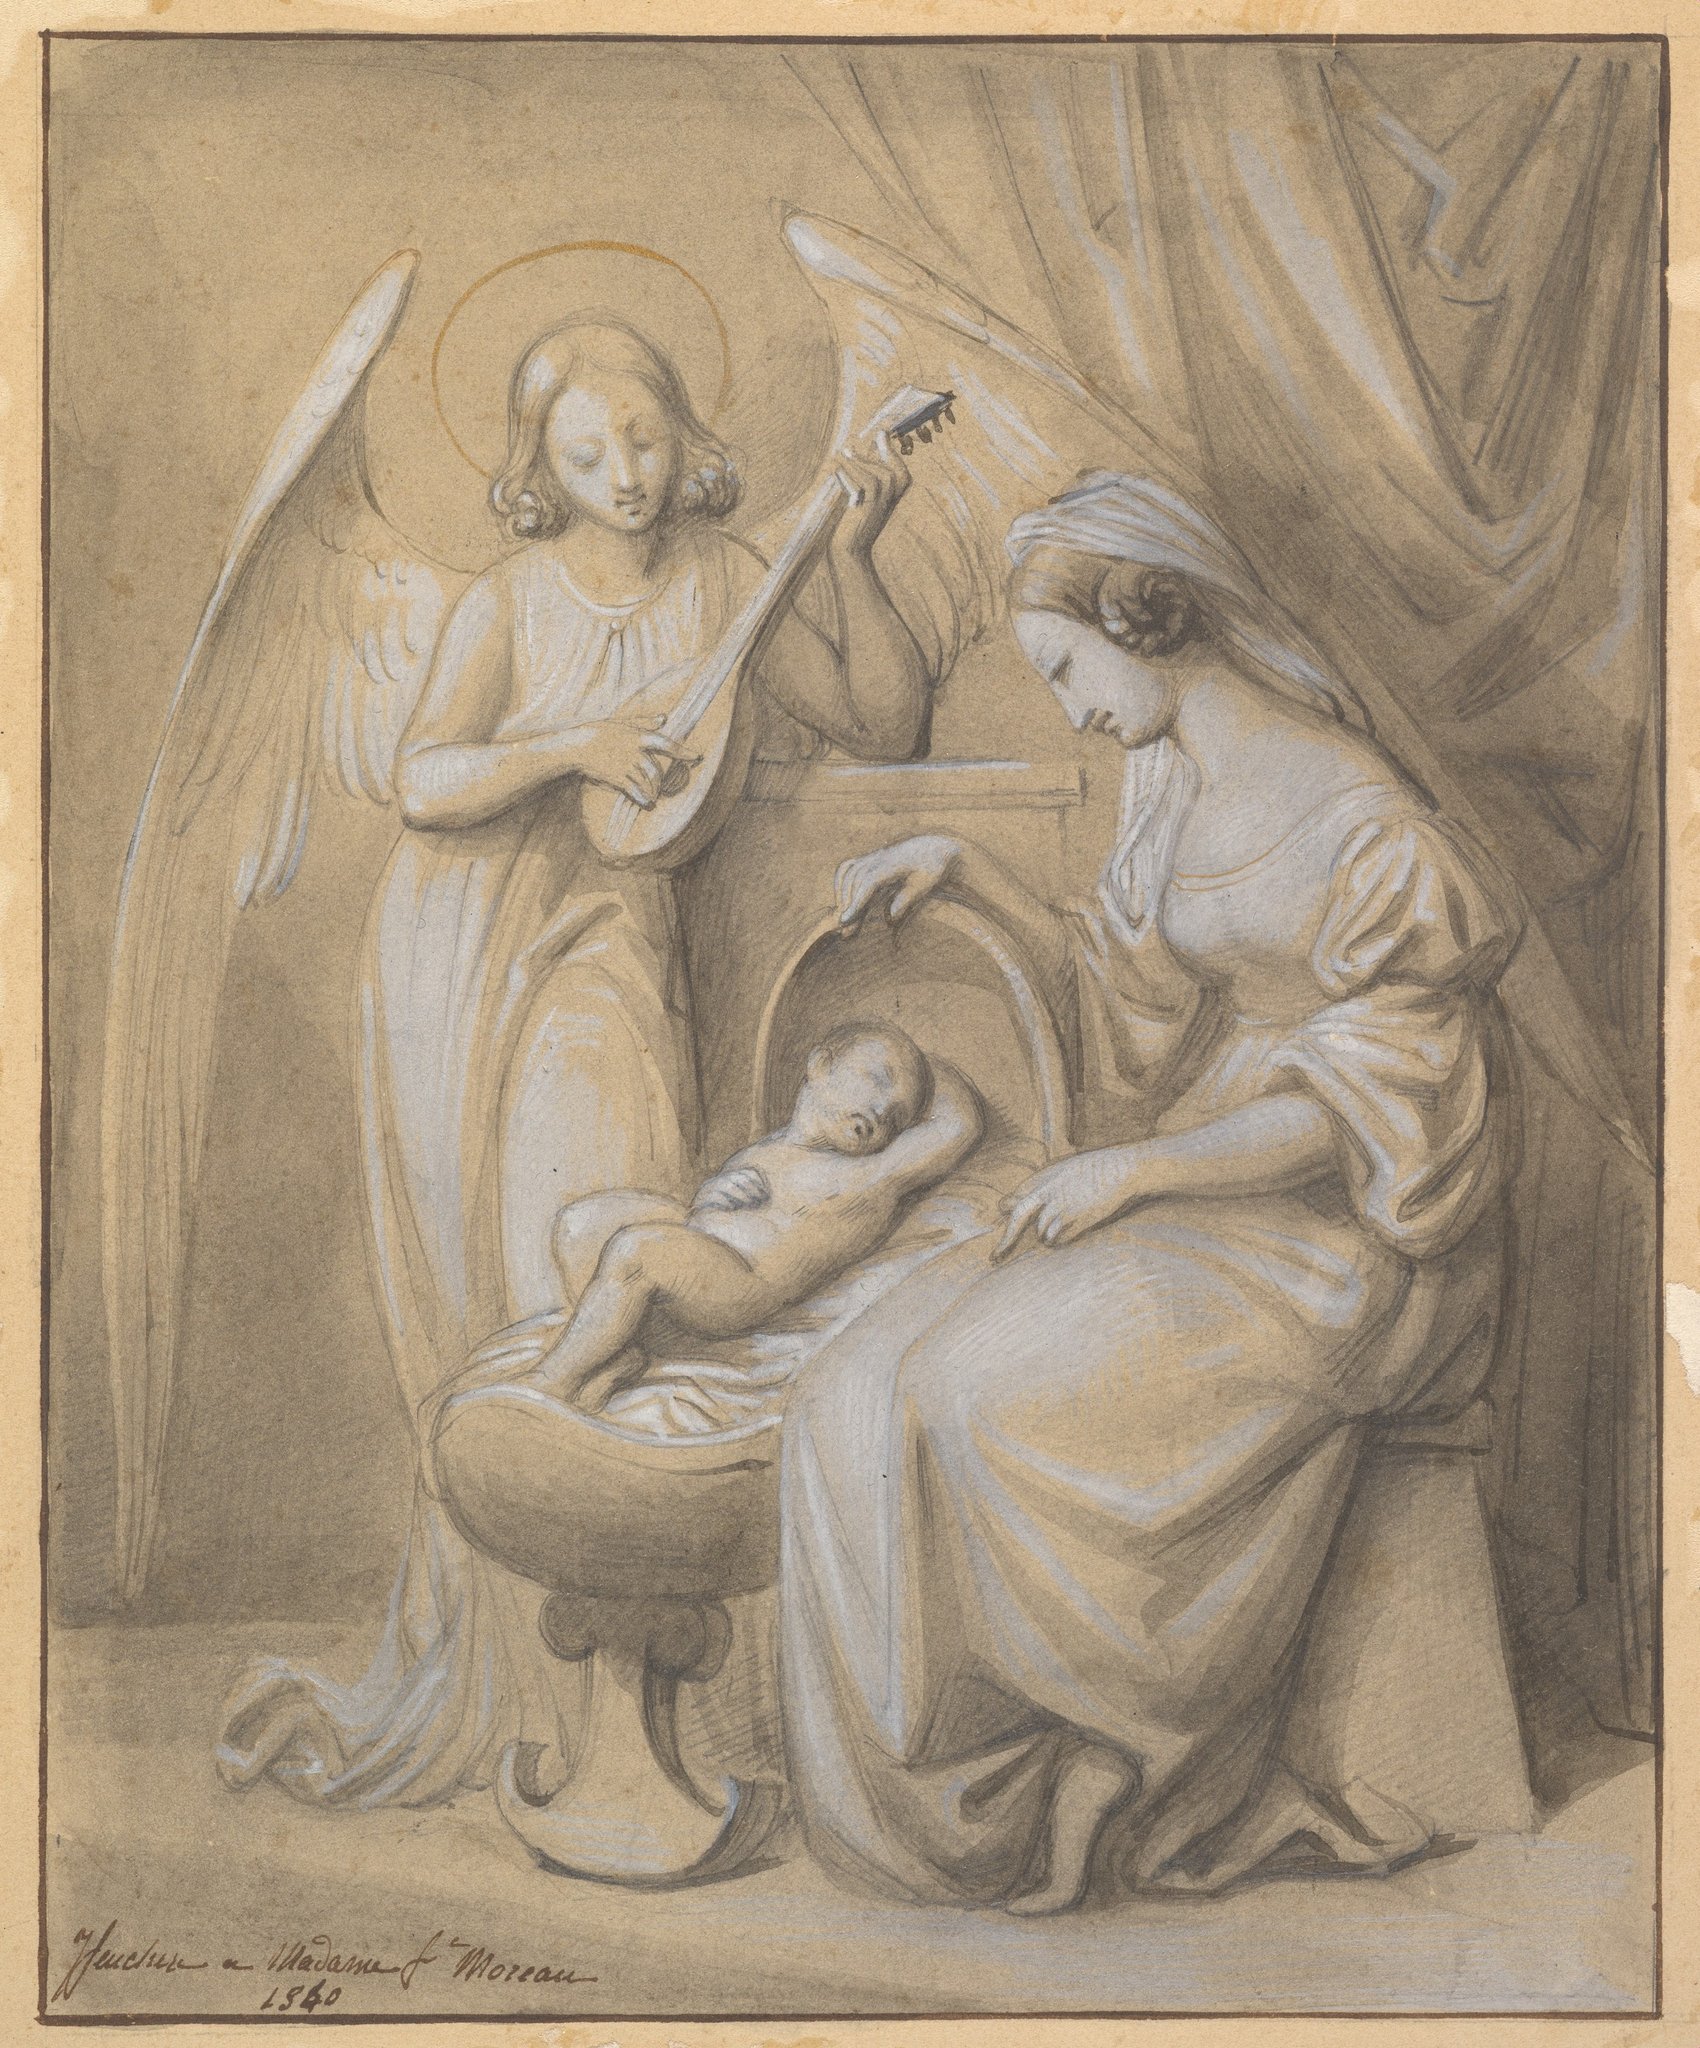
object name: drawing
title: Virgin and Child Adored by a Lute-Playing Angel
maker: jean-jacques feuchère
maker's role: artist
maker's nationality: french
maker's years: 1807-1852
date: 1820-1852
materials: gold, gouache, graphite, paper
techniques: brush, wash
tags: lutes,angels,madonna and child